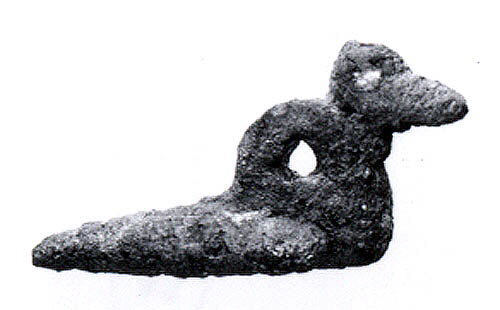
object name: pendant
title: Pendant in the form of a duck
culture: iranian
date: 800-601 BCE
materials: bronze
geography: iran, luristan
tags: ducks